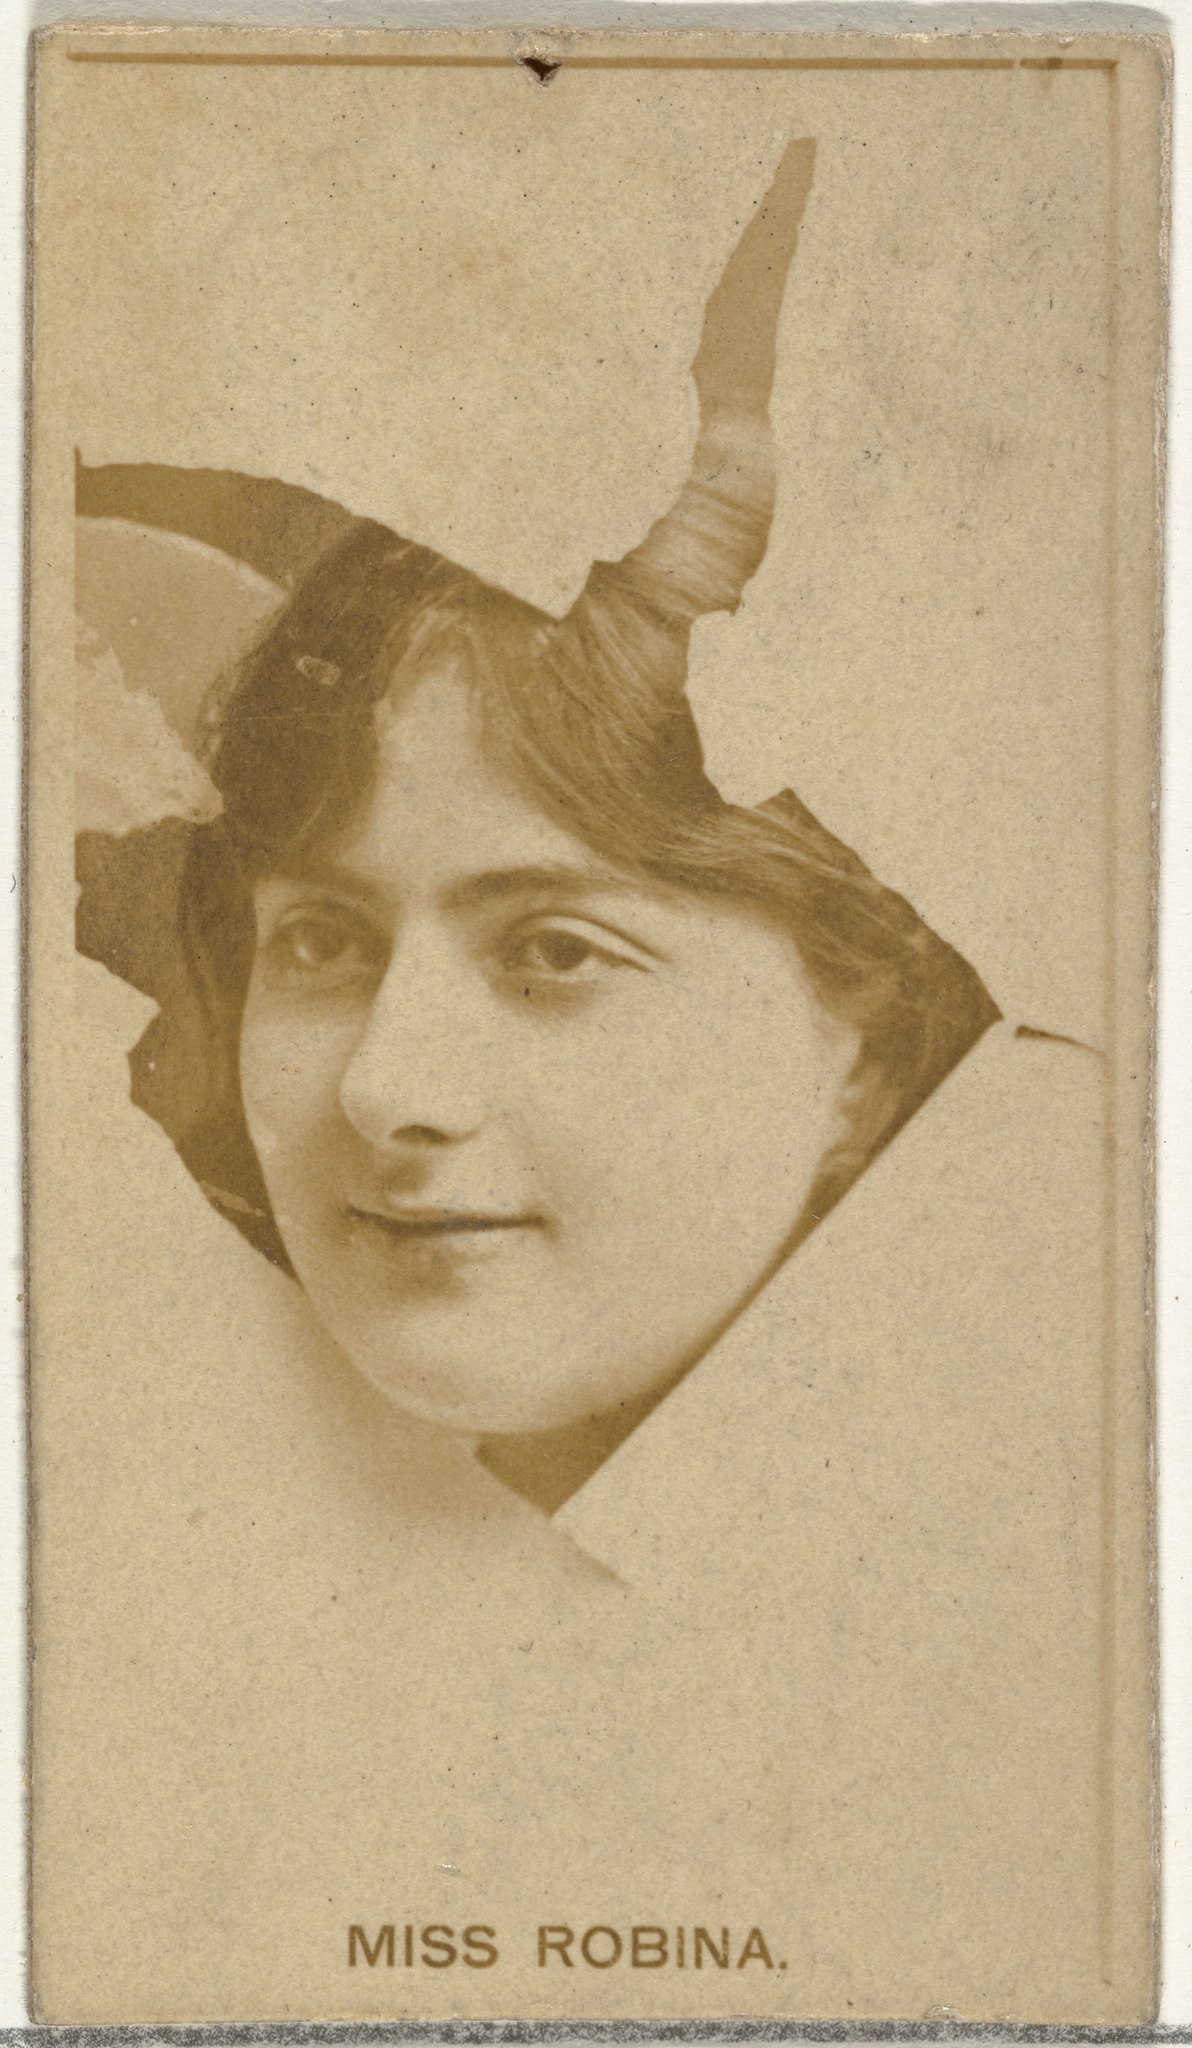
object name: photograph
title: Miss Robina, from the Actors and Actresses series (N145-8) issued by Duke Sons & Co. to promote Duke Cigarettes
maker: w. duke, sons & co.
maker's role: publisher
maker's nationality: american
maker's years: 1870-1920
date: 1891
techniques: albumen silver print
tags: portraits,women,actresses